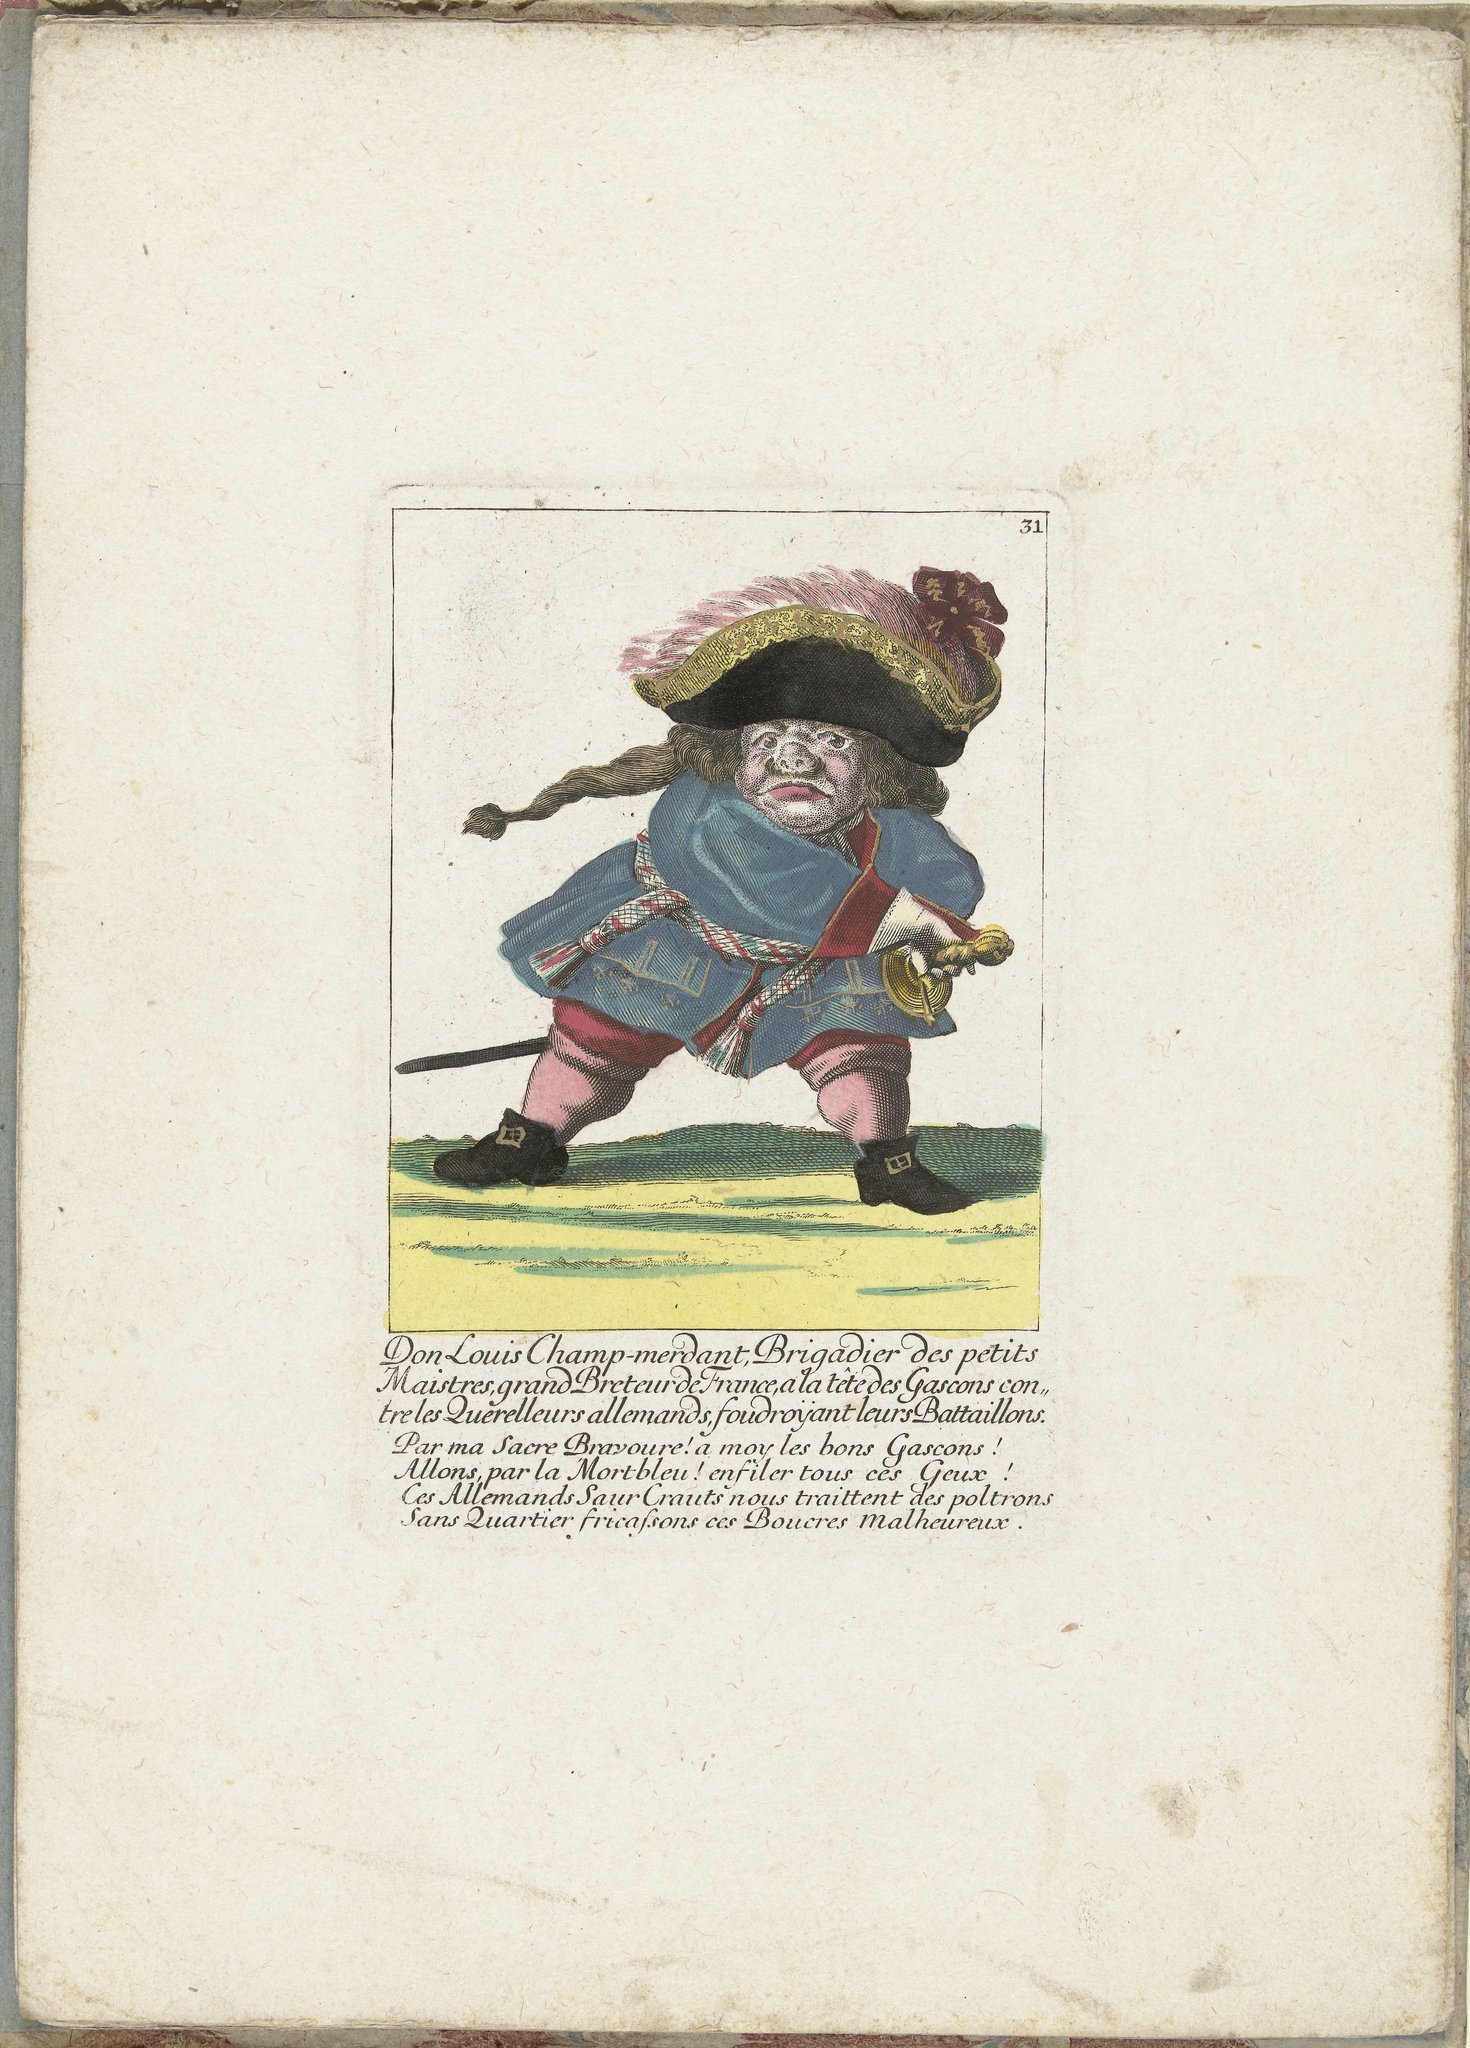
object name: caricature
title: De Franse kleine mens Don Luis Champ-merdant, ca. 1710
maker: martin engelbrecht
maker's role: print maker, publisher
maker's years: 1684-1756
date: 1705-1715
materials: paper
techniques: engraving, etching, hand coloring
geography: augsburg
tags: caricatures (human types), little people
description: De Franse kleine mens Don Luis Champ-merdant. In het onderschrift onder de titel een vierregelig vers in het Frans. Genummerd rechtsboven: 31. Onderdeel van een losbladige uitgave uit ca. 1710 van een serie karikaturen van kleine mensen, bekend als Het Dwergentooneel.